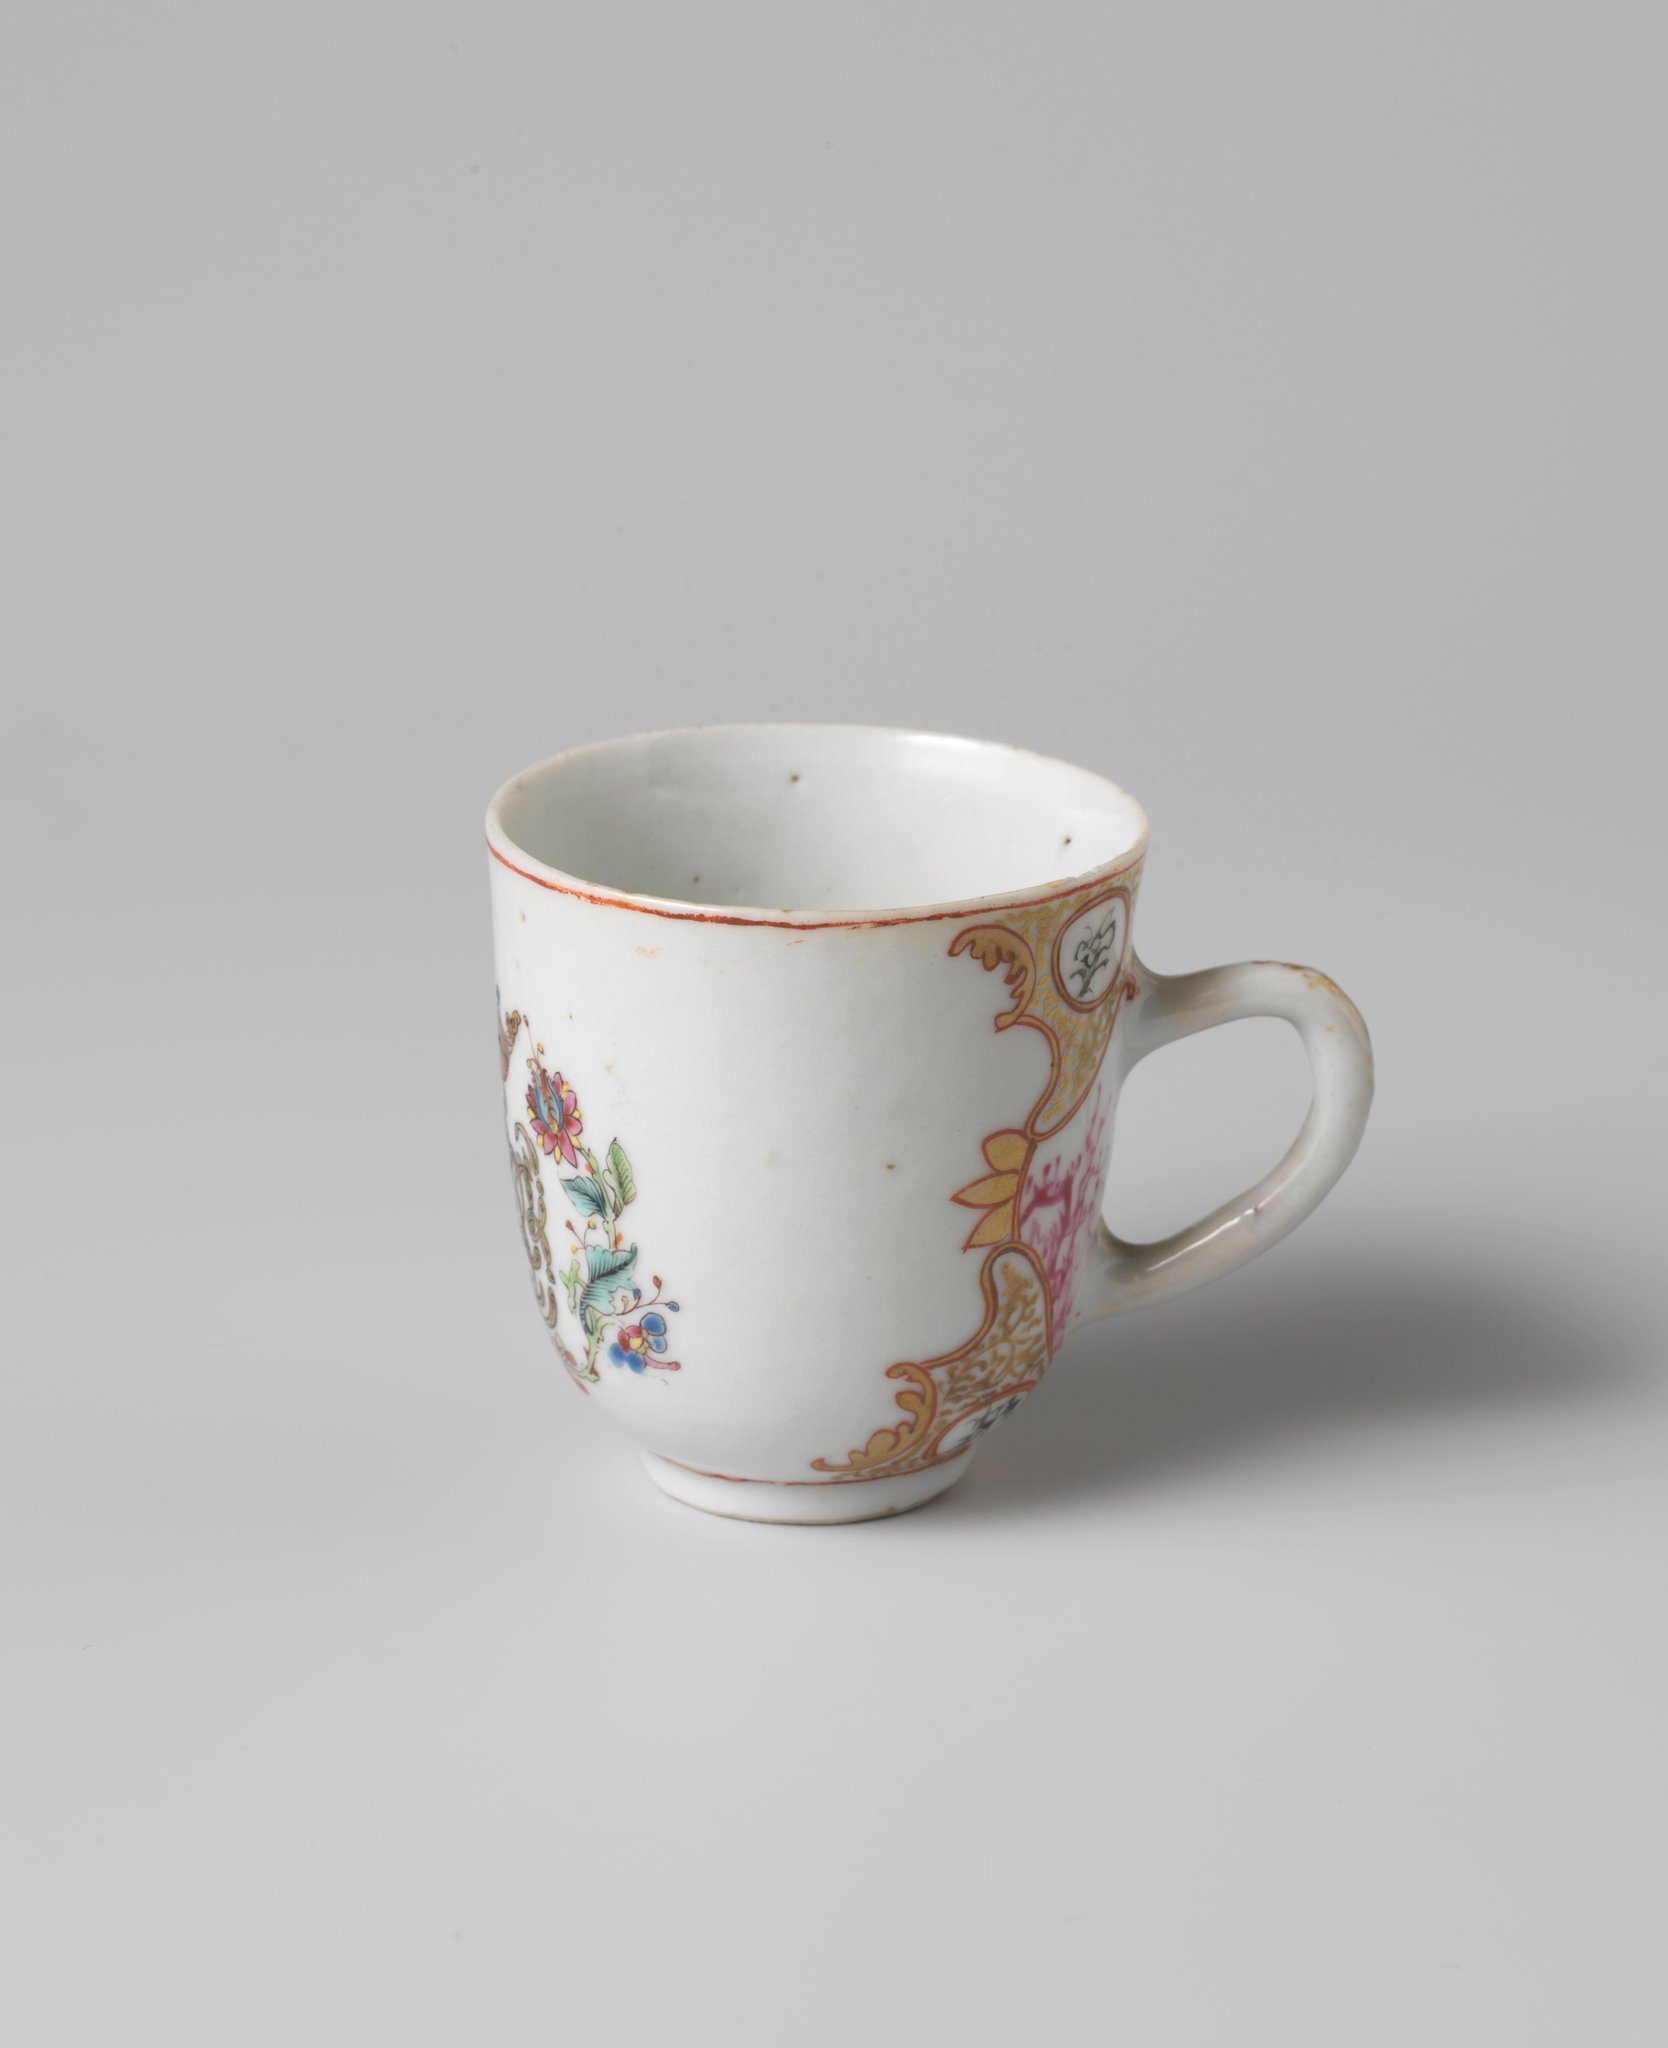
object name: cup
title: Cup with handle with a crowned, illegible monogram surrounded by two flower sprays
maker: Anonymous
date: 1750-1774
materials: glaze, gold, paint, porcelain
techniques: firing, gilding, turning, vitrification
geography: china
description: Oorkop van porselein, beschilderd op het glazuur in blauw, rood, roze, groen, geel, zwart en goud. Op de buitenwand een gekroond, onleesbaar monogram omringd door twee bloemtakken; rond het oor bloemranken met daarin uitgespaard een cartouche met een landschap en vier medaillons met planten. Twee chips in de rand. Europese voorstelling in emailkleuren.